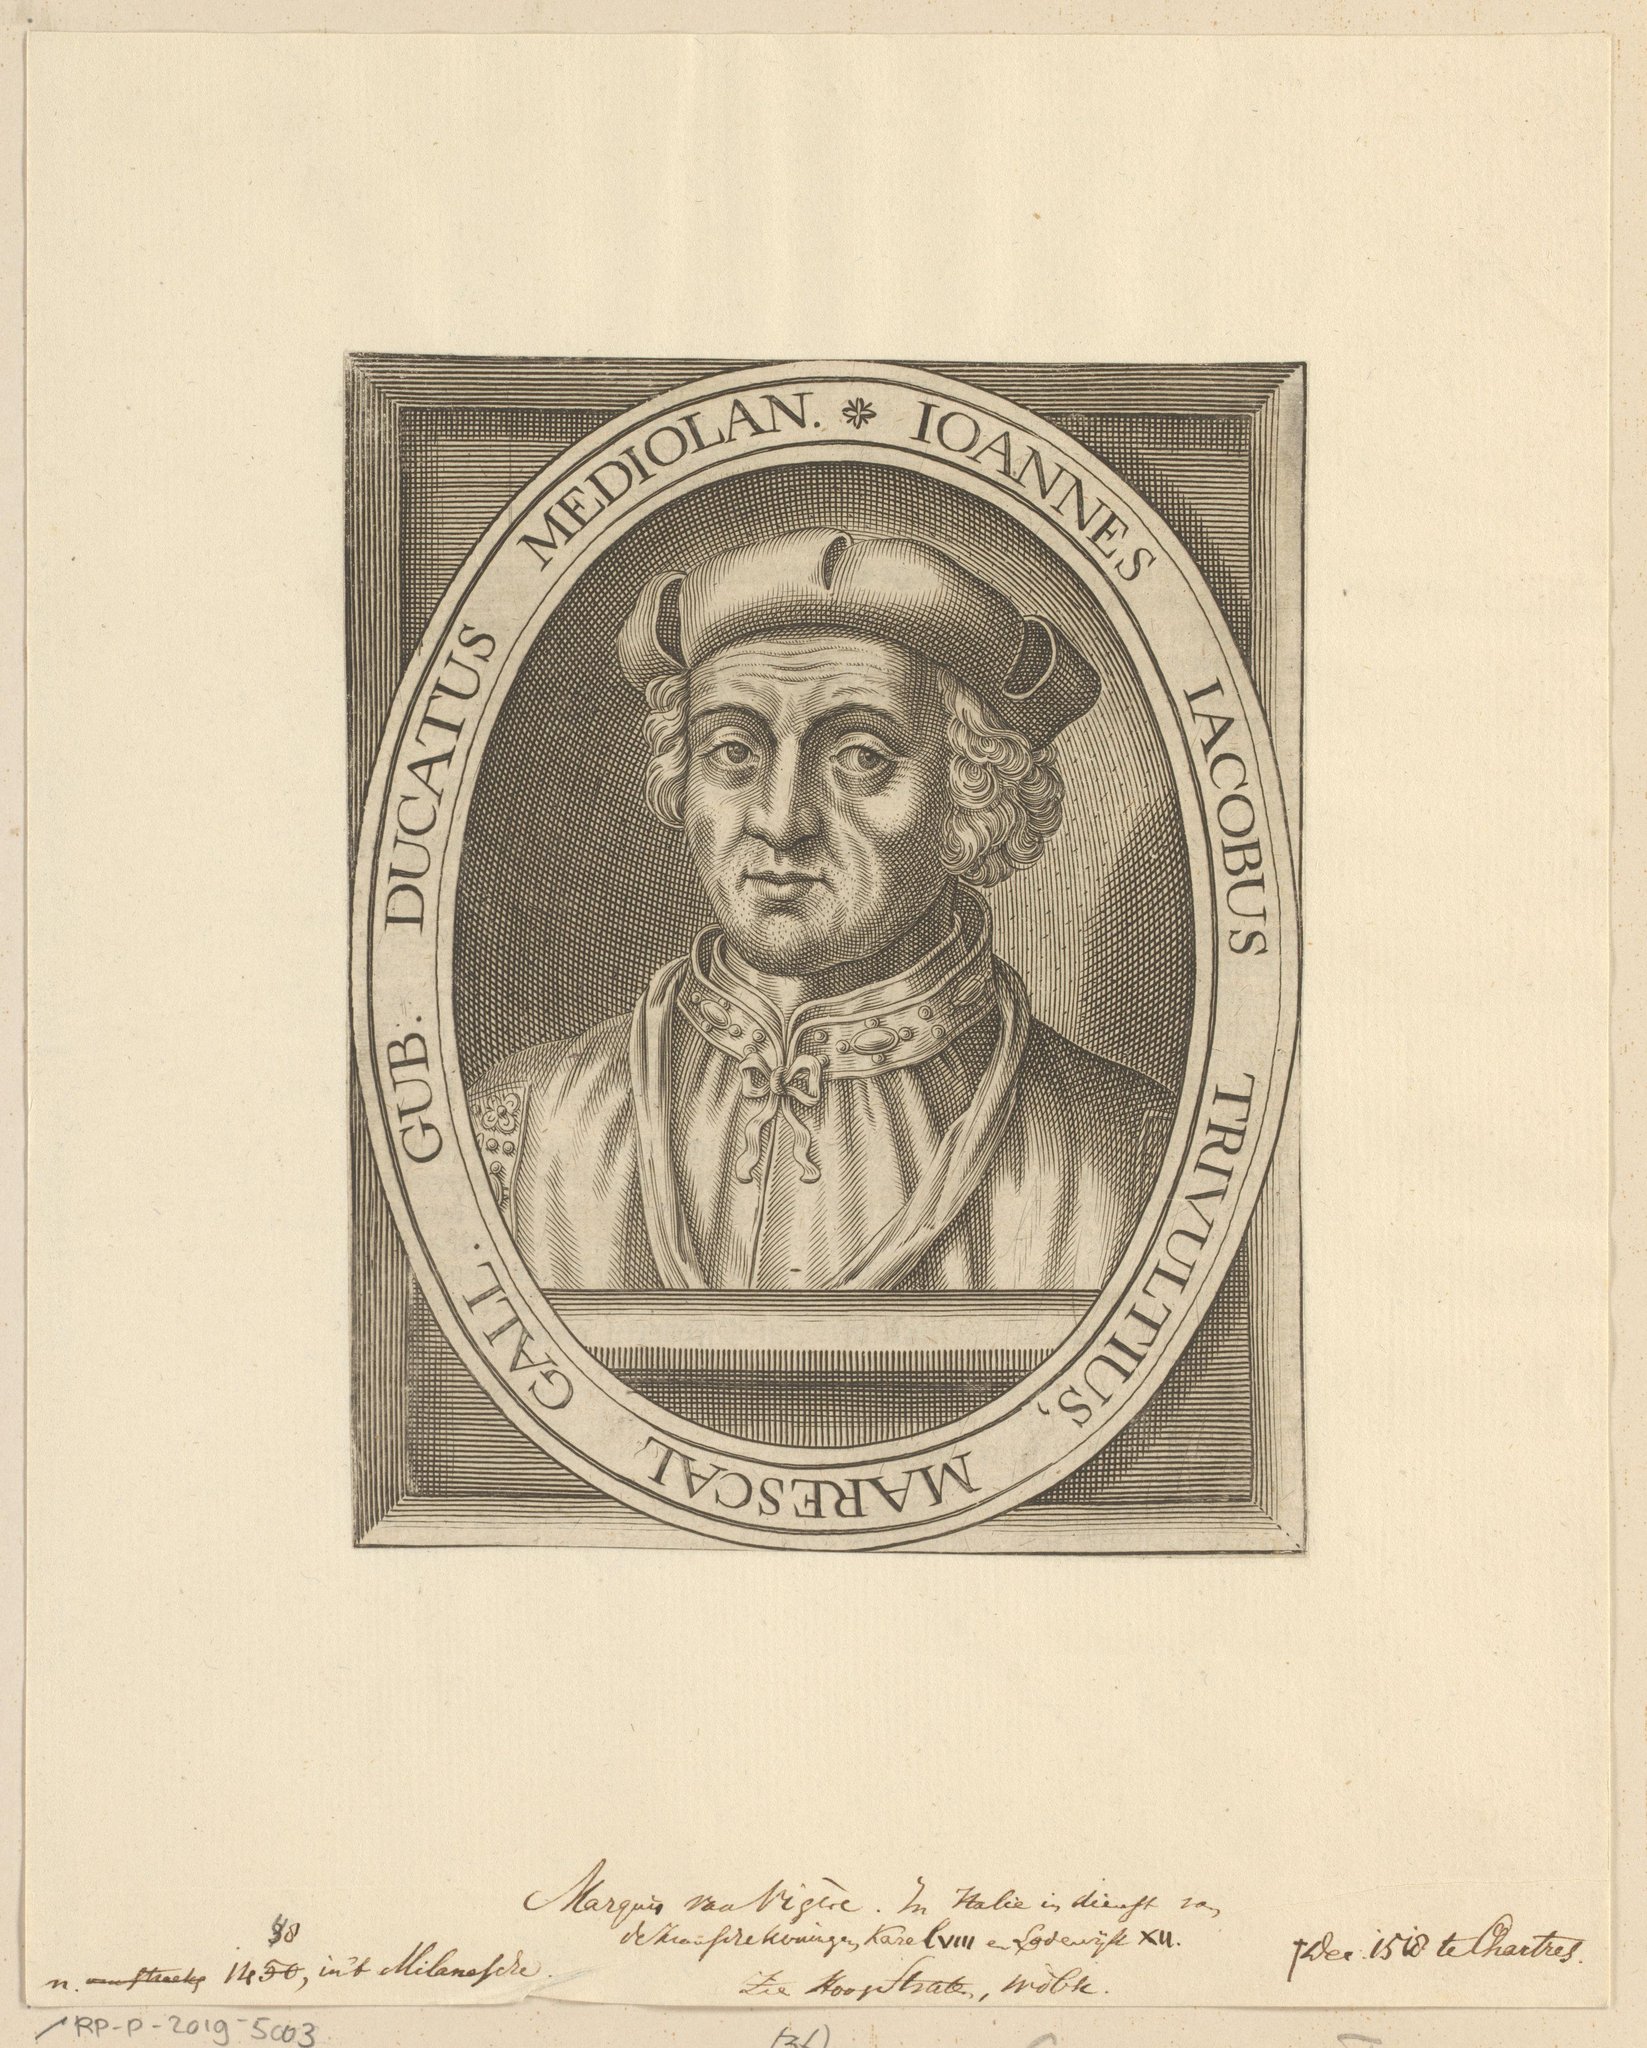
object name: book illustration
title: Portret van Gian Giacomo Trivulzio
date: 1617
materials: paper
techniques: engraving, letterpress printing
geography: delft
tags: politician, historical persons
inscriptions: inscription: ‘1448 in Milano[...]’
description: Prent uit: Clerck, Nicolaes de. Tooneel der beroemder hertogen, princen, graven ende krygs-helden (...). Delft: Nicolaes de Clerck, 1617.